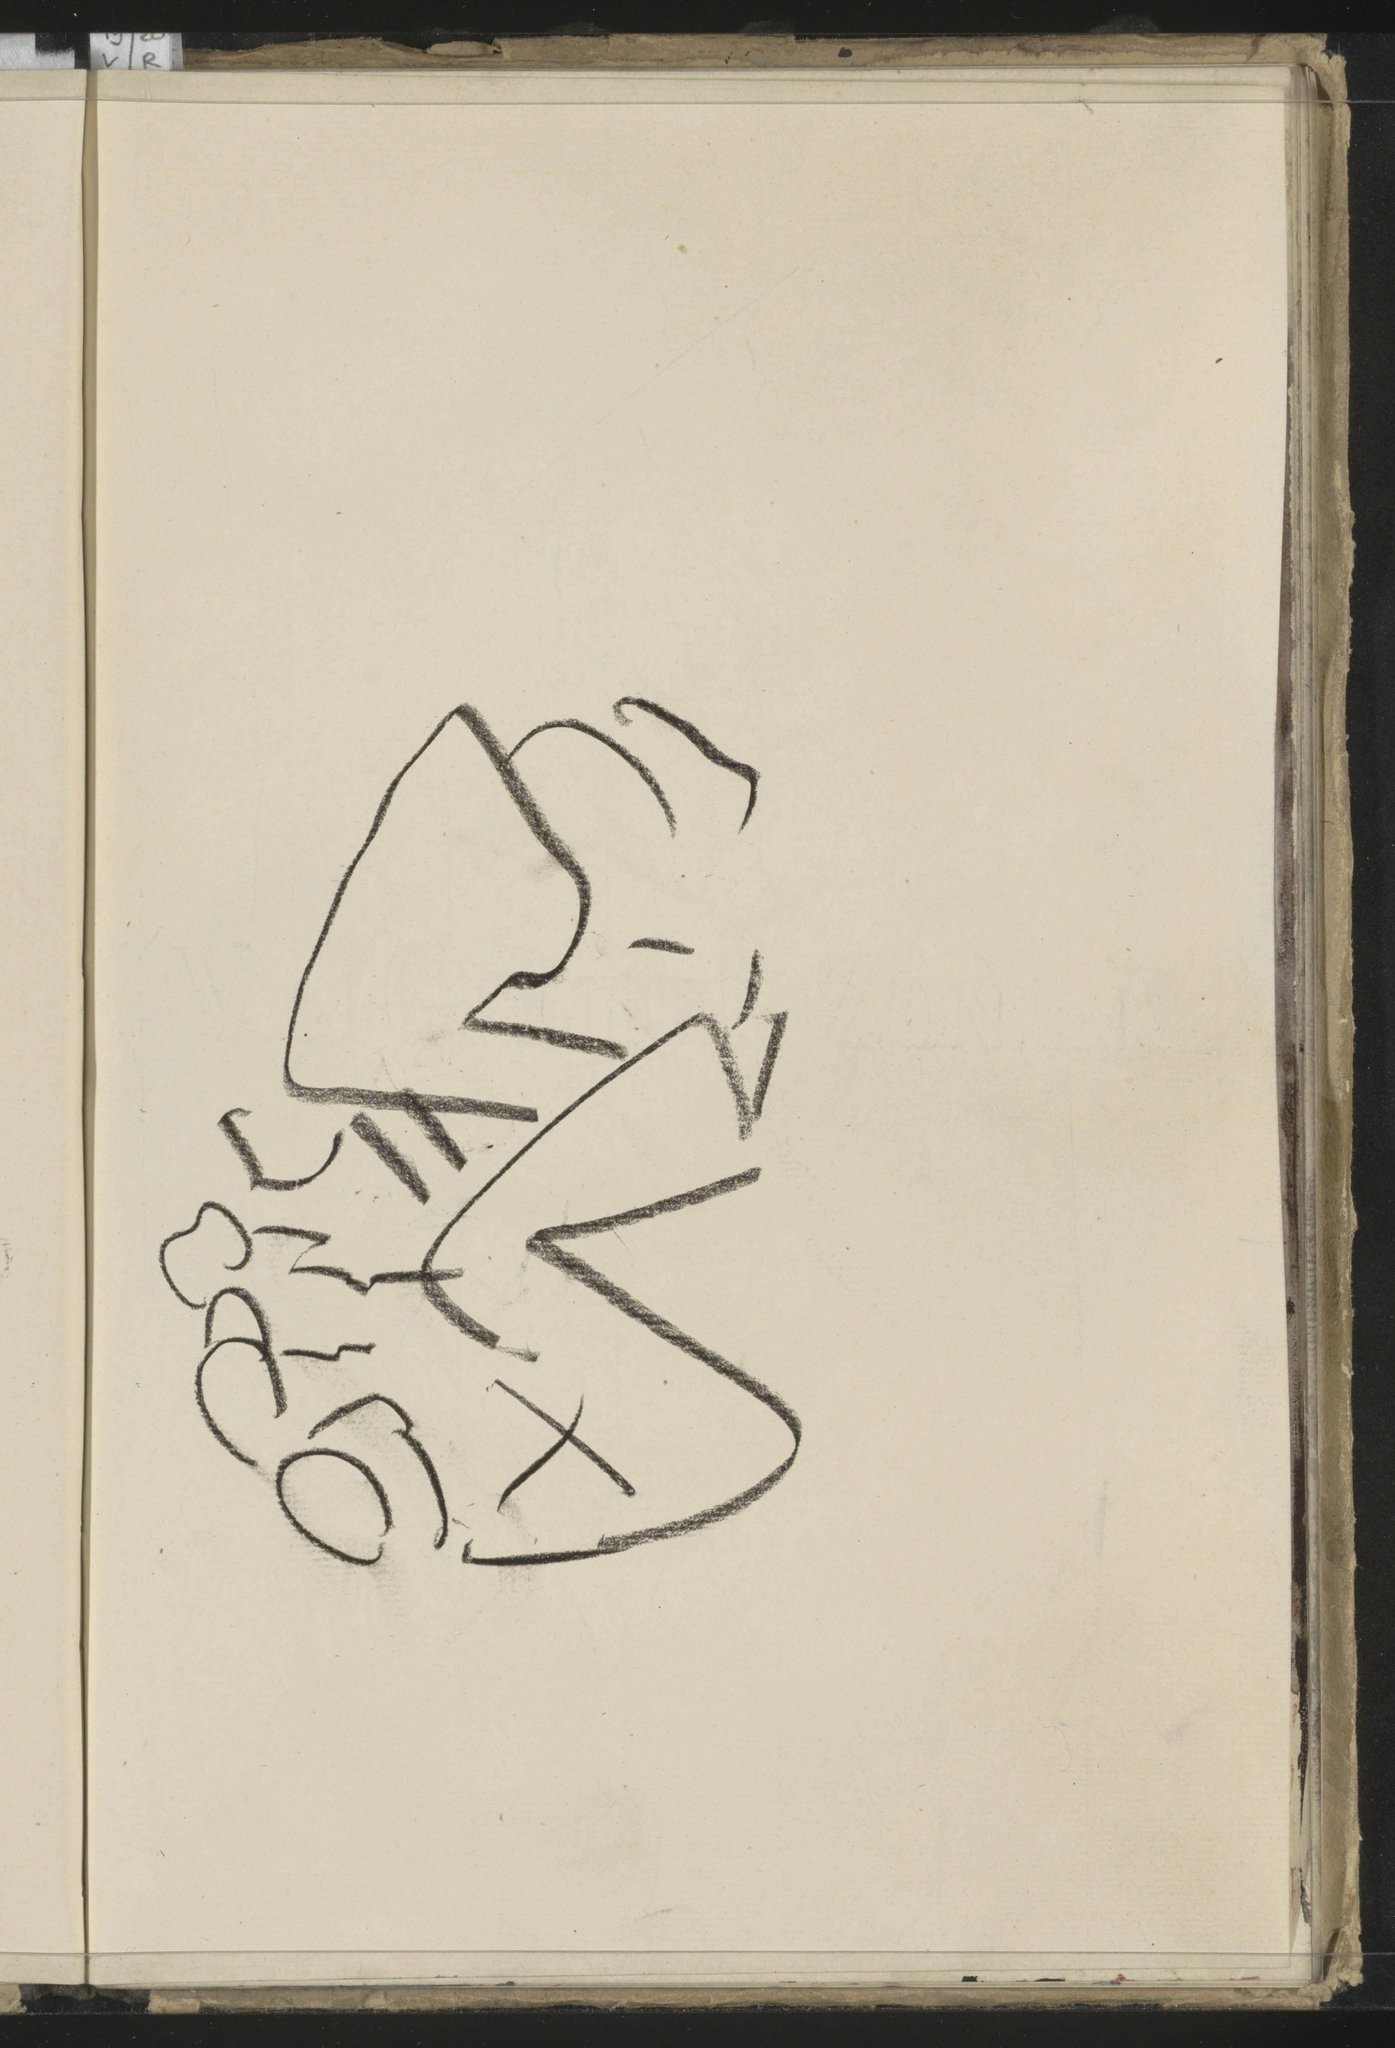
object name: sketchbook leaf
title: Zittende en een knielende figuur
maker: carel adolph lion cachet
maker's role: draughtsman, print maker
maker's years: 1864-1945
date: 1890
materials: chalk, paper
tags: sitting figure, kneeling figure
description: Blad 16 recto uit een schetsboek met 38 bladen.